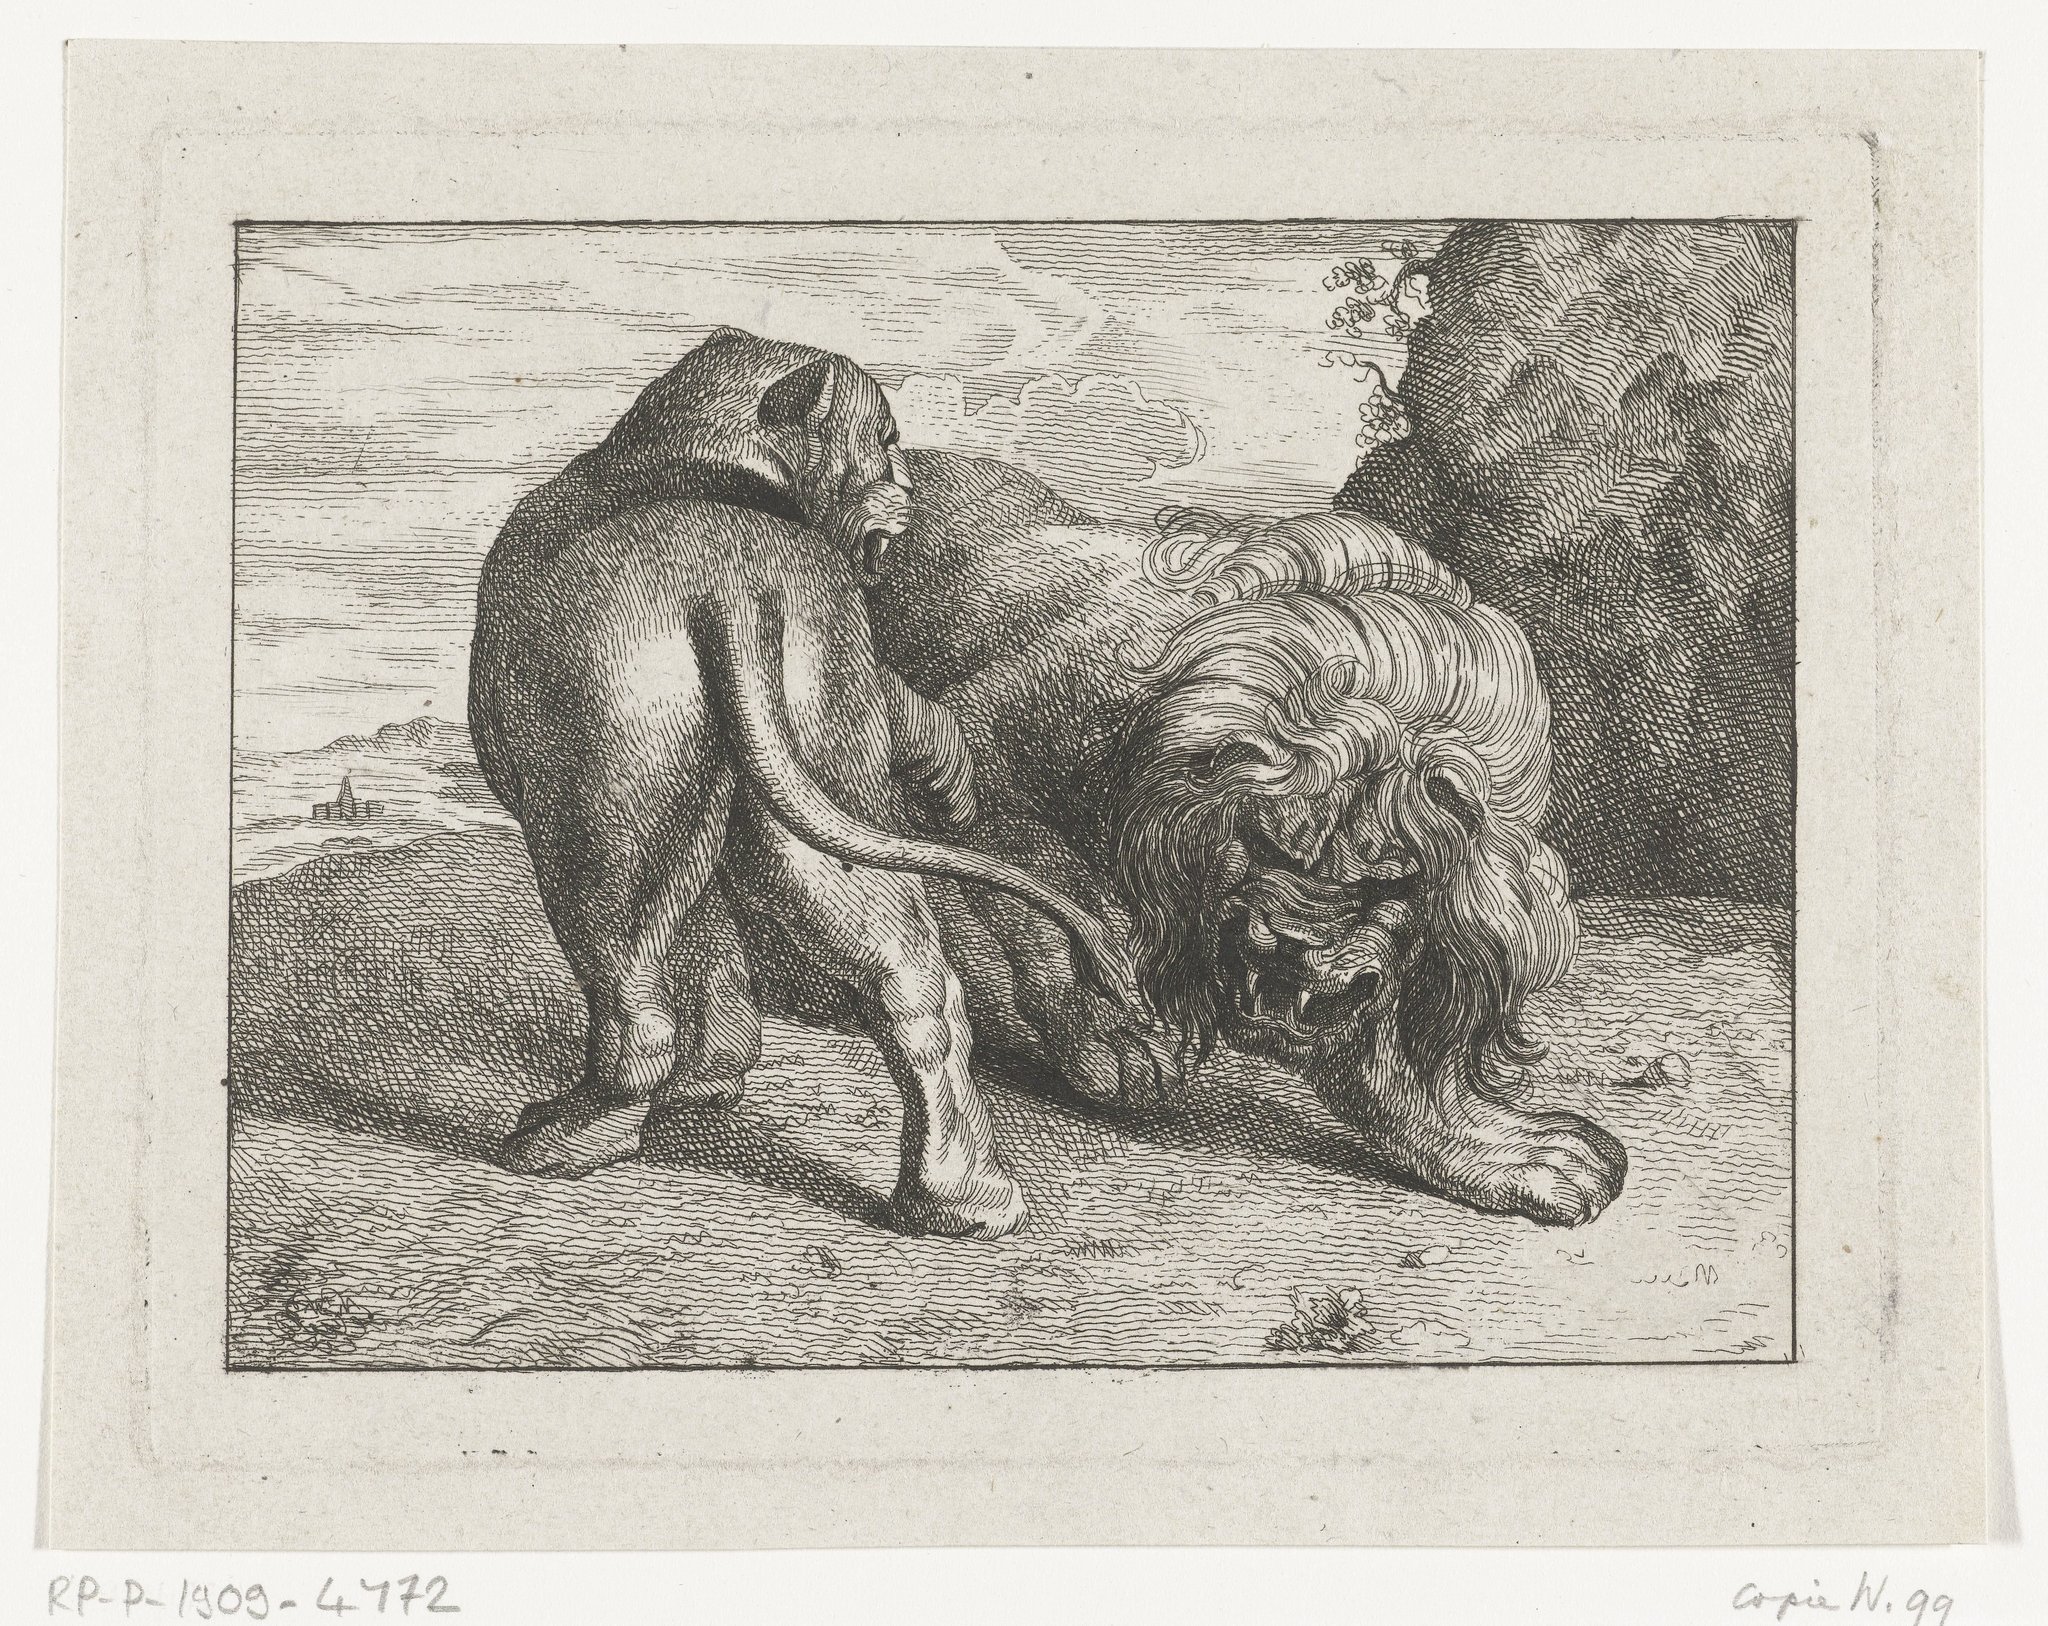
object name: print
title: Leeuw met leeuwin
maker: Anonymous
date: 1750-1900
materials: paper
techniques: etching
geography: netherlands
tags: beasts of prey, predatory animals: lion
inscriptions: collector's mark: Lugt 2228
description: Een leeuw en een leeuwin draaien rondjes om elkaar heen. De leeuw laat zijn tanden zien. Prent uit een serie van vier prenten met voorstellingen van leeuwen naar Pieter Paul Rubens.